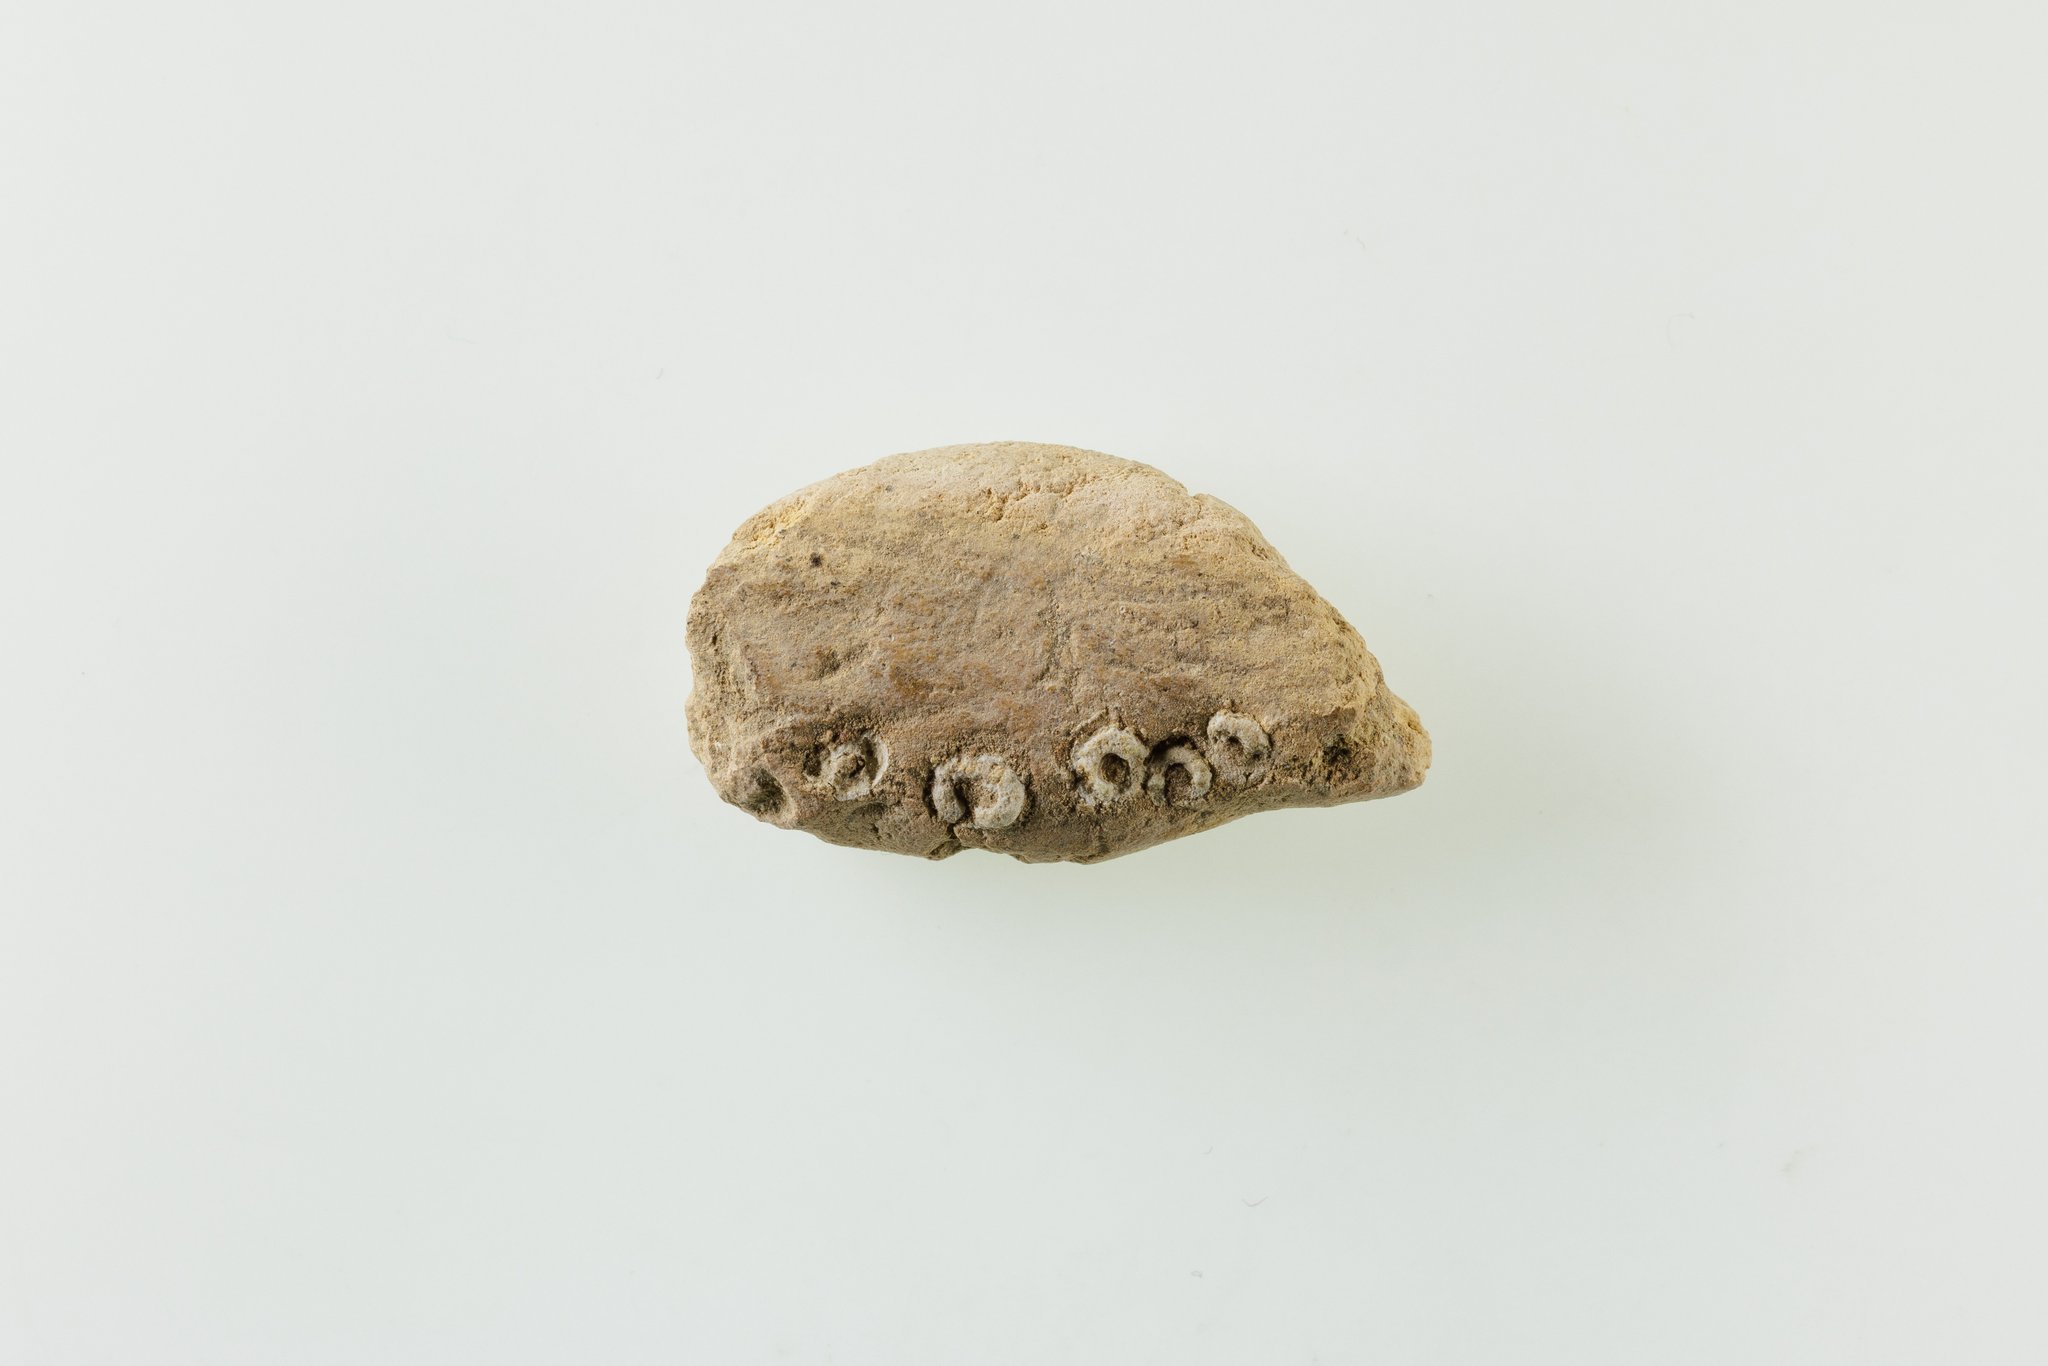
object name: fragment, clay, ring bead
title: Fragment of clay lump with imbedded ring beads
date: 1802-1450 BCE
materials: clay, faience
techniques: firing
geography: egypt